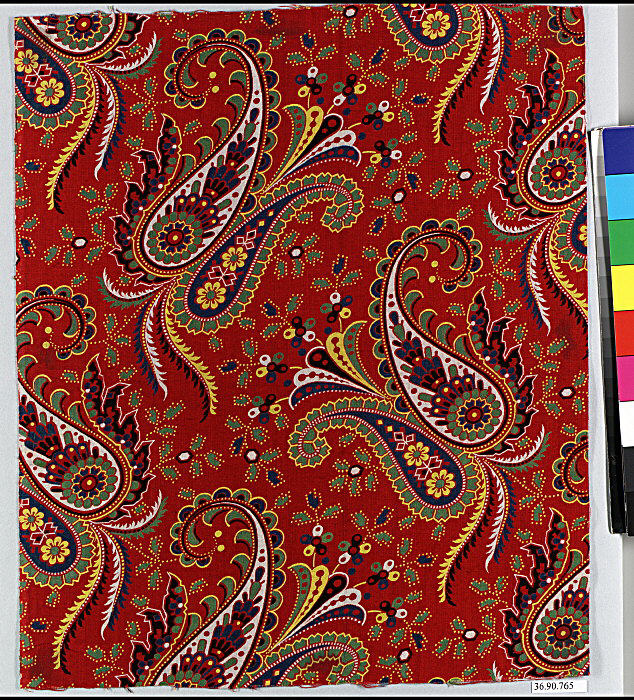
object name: piece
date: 1867-1900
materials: cotton